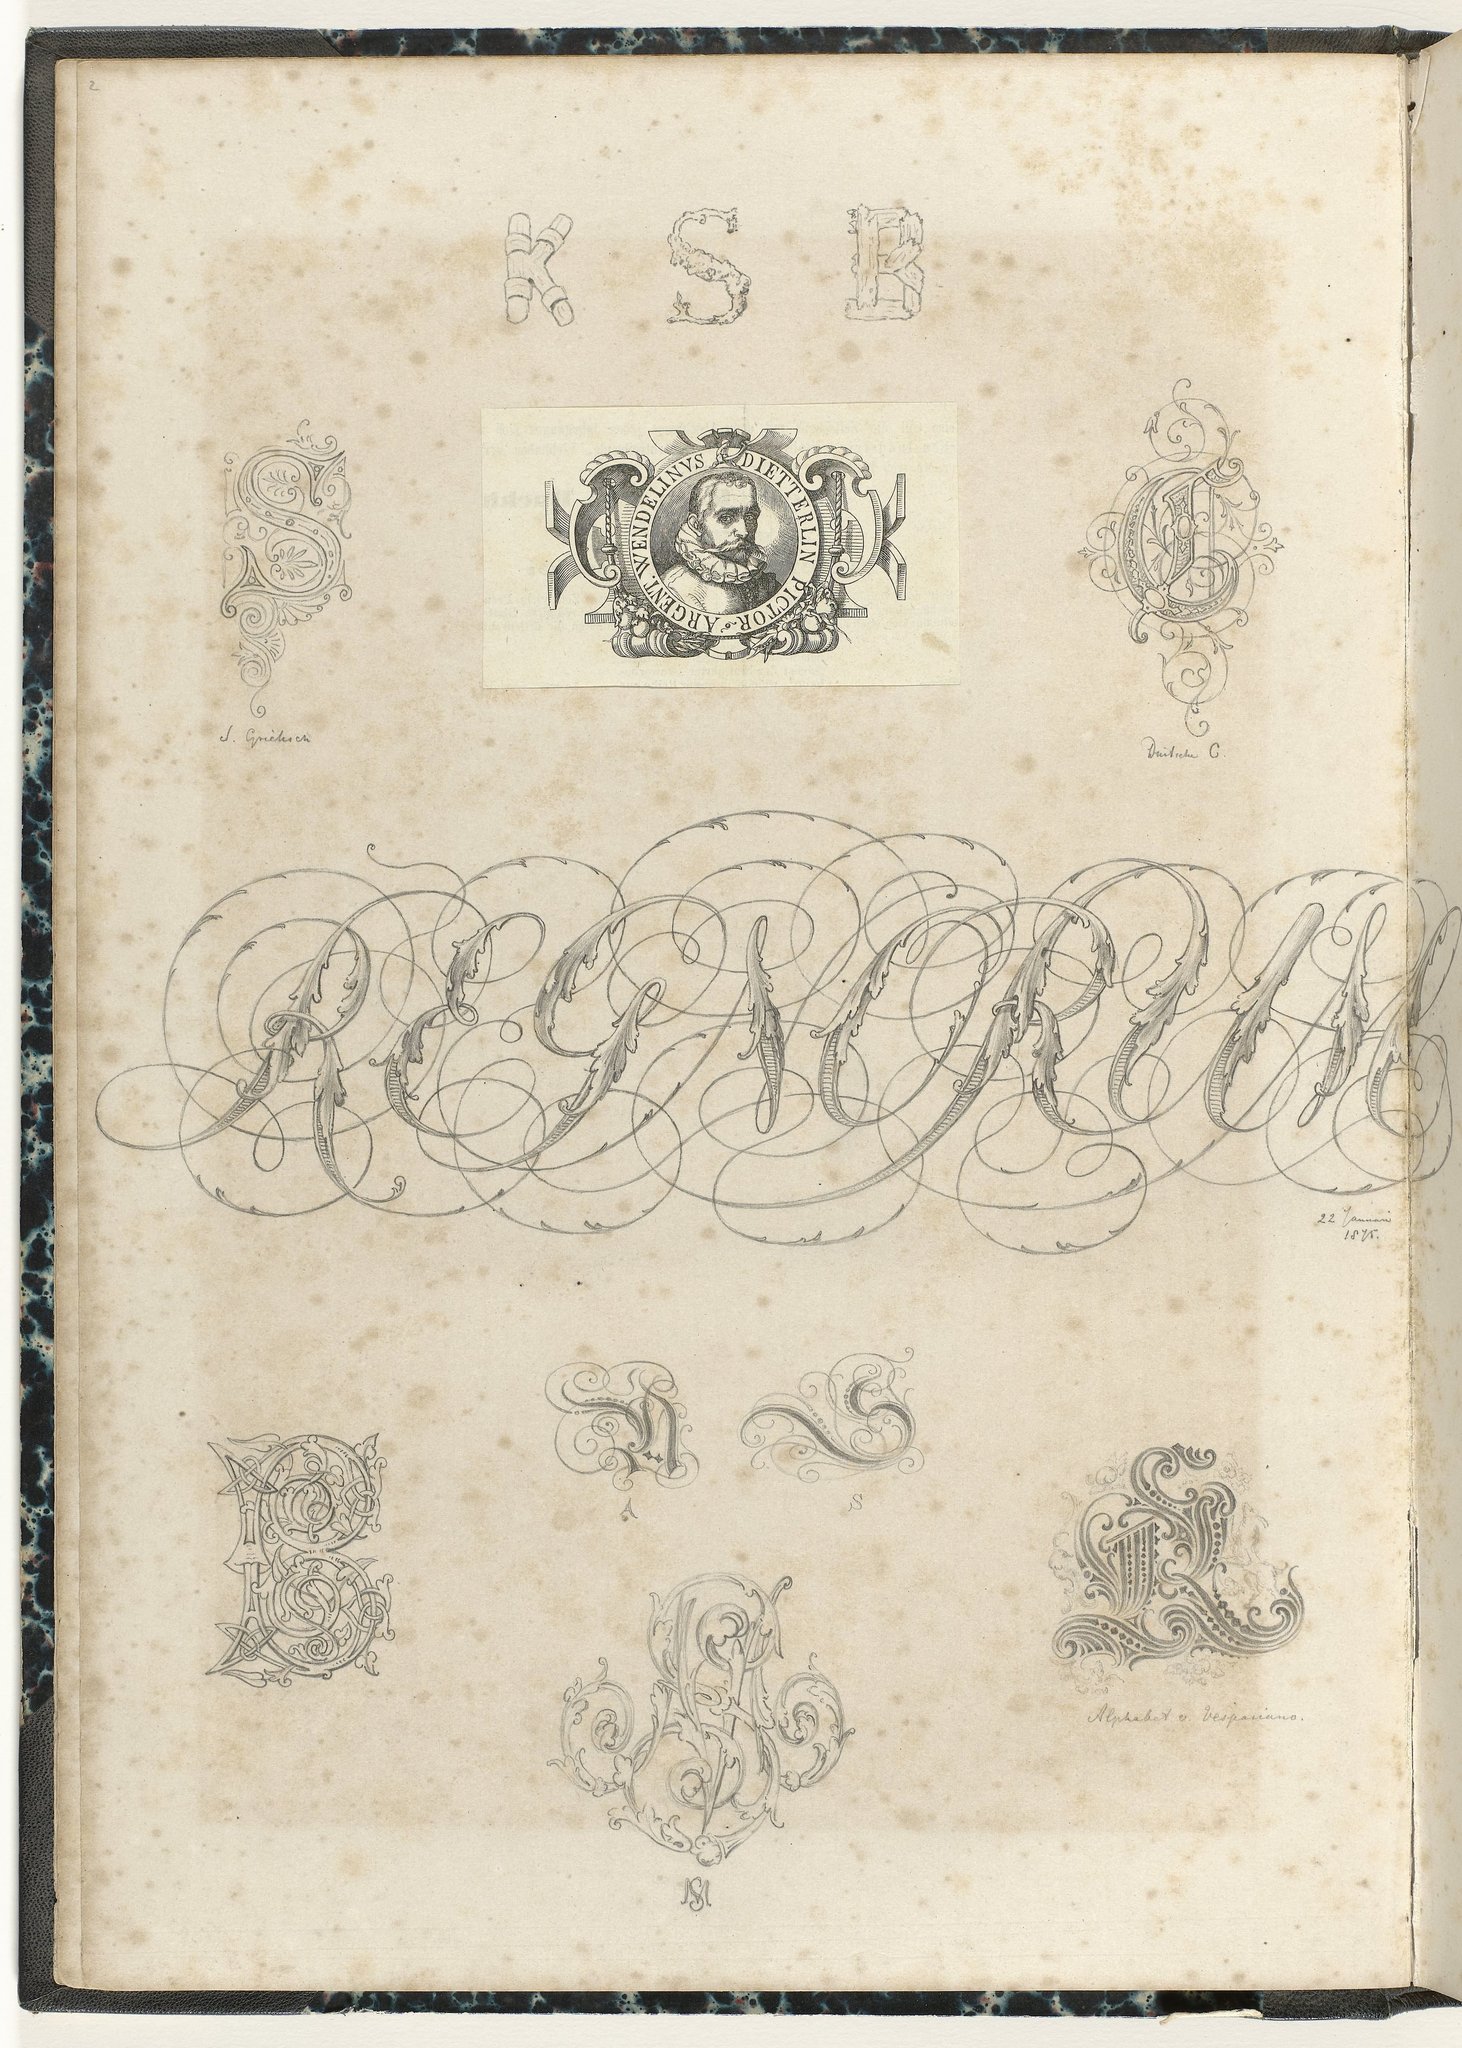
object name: print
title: Letters en portret in cartouche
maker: Anonymous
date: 1875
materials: paper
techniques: drawing, engraving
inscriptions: annotation: ‘Duitsche C’, annotation: ‘J. Grieks ch(?)’, annotation: ‘Alphabet v. Vespasiano’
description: Blad met in het midden een aantal onderling verweven letters, daaromheen tien losse letters. Midden boven is een prent van een man in een cartouche geplakt, rondom het portret staat de tekst: Argent Wendelinvs Dietterlin Pictor.